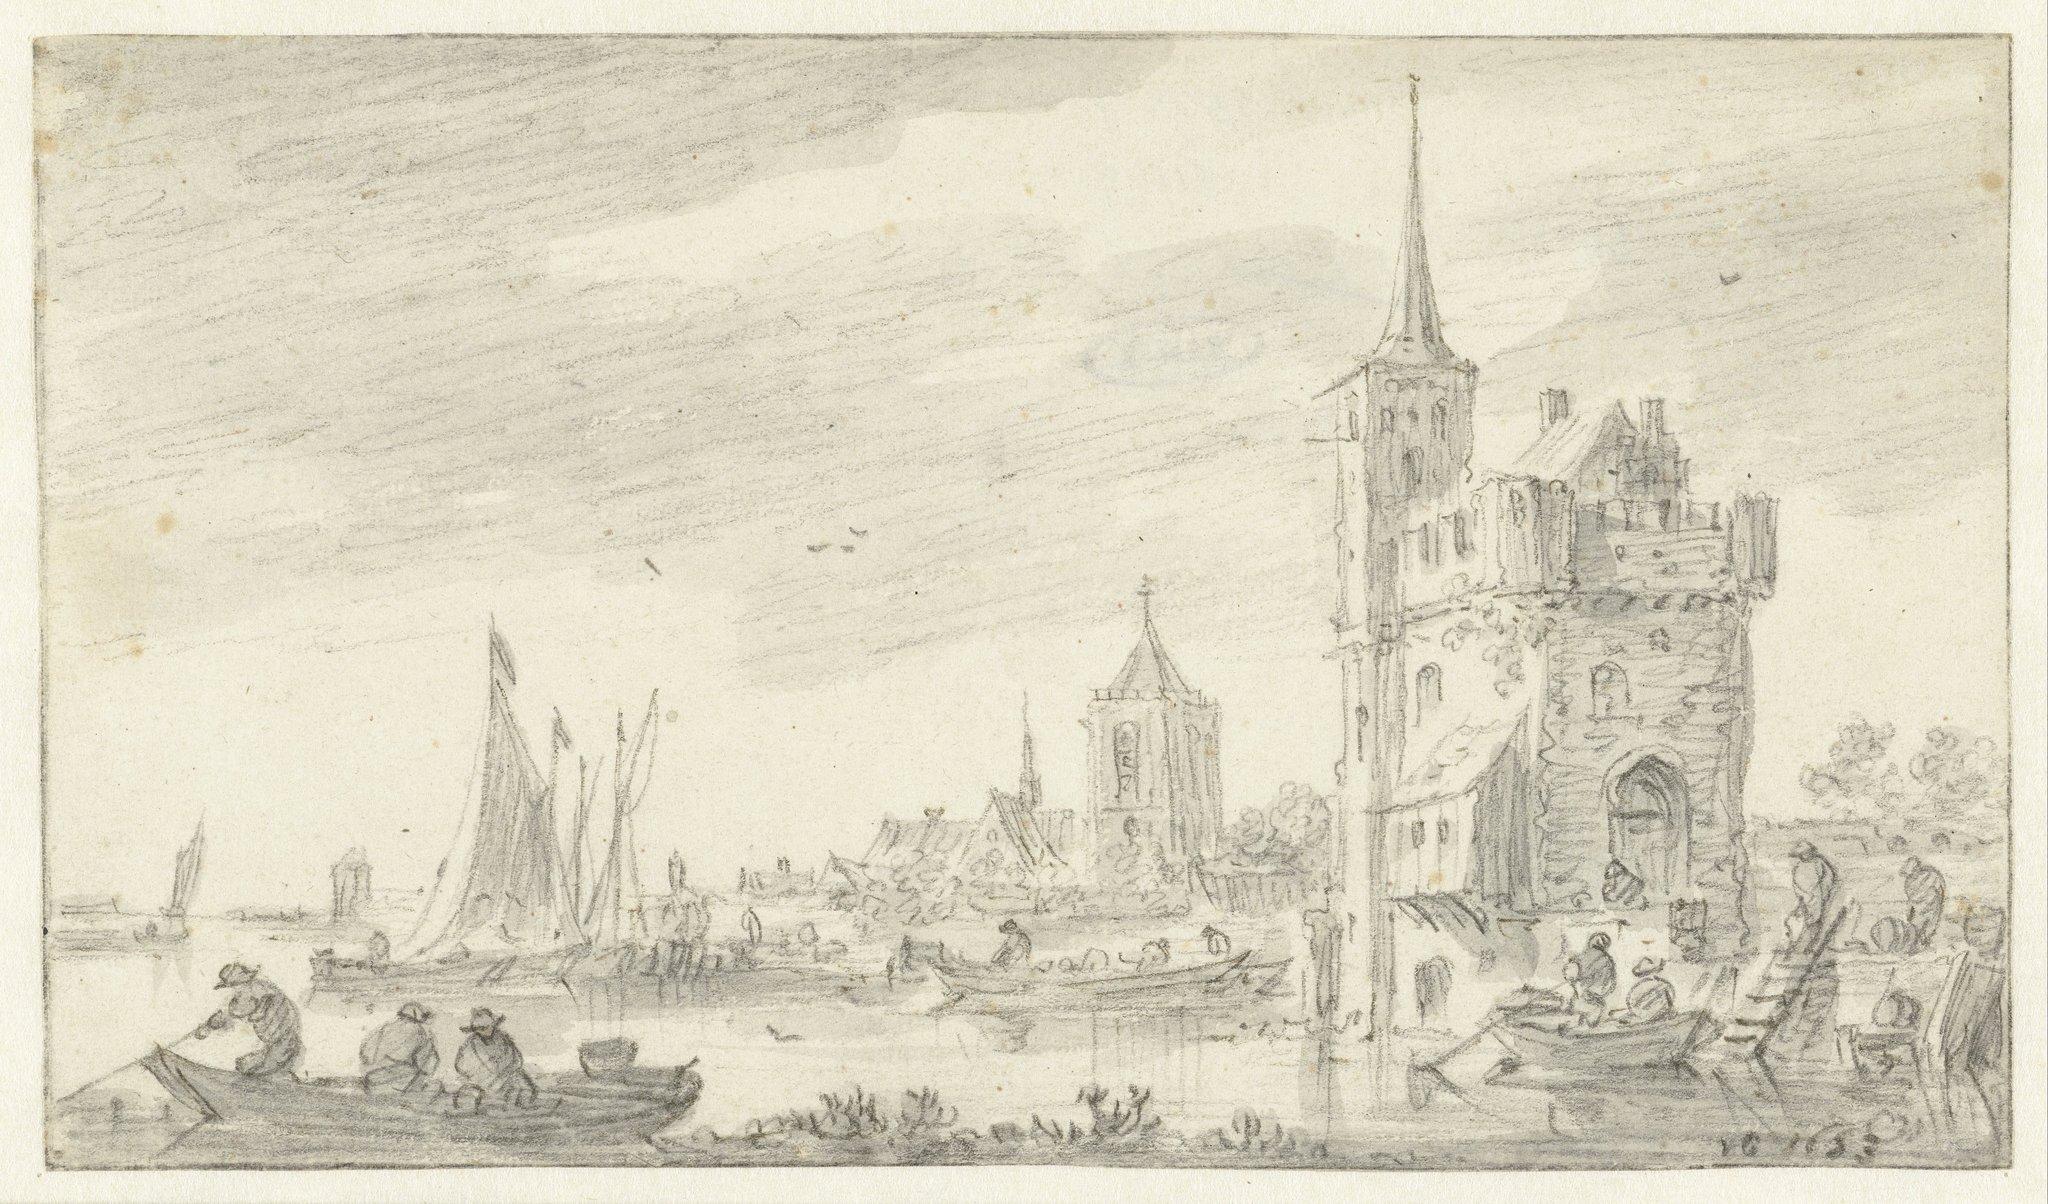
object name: drawing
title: Stadspoort aan de stadswal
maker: jan van goyen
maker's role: draughtsman, painter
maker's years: 1596-1656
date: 1653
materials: chalk, paper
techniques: brush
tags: city-gate, quay